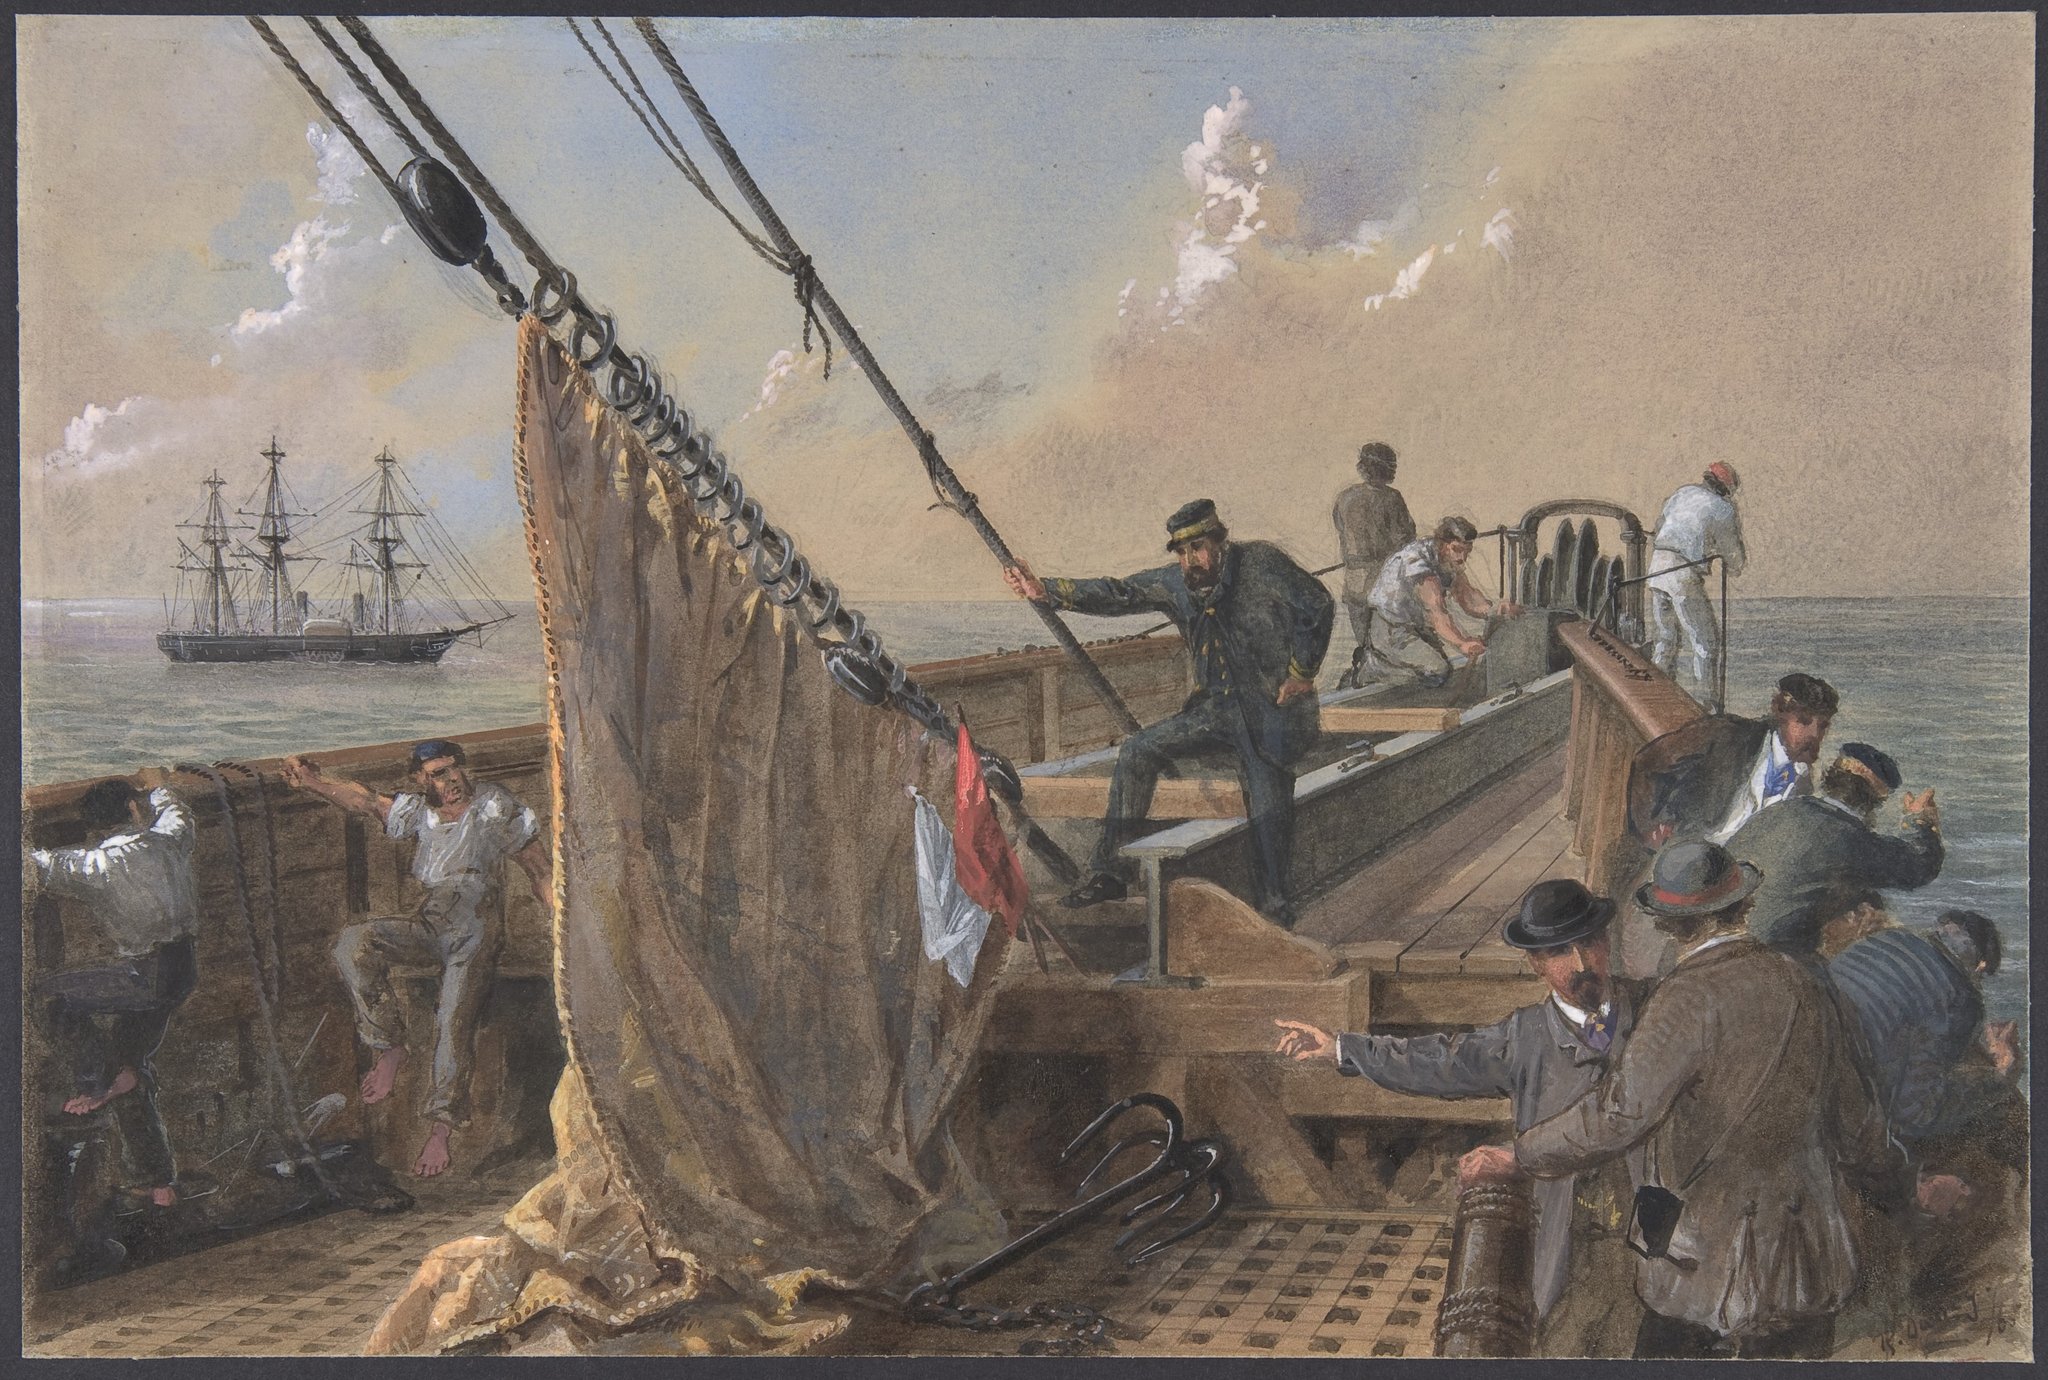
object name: drawing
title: Forward Deck of the Great Eastern Cleared for the First Attempt to Grapple for the Lost Cable, August 11th, 1865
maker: robert charles dudley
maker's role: artist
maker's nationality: british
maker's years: 1826-1909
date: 1865-1866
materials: gouache, graphite, watercolor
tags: men,ships,transatlantic cable